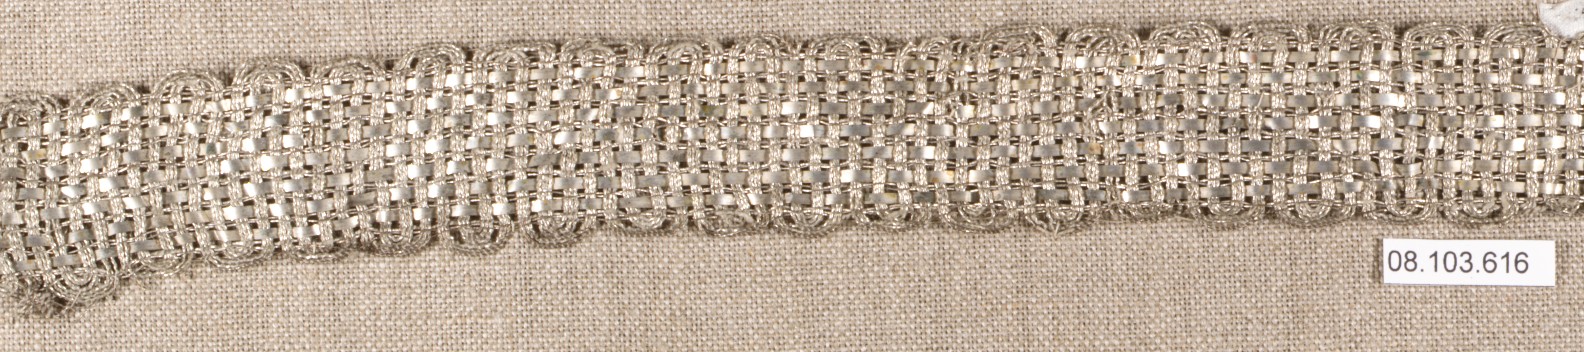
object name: galloon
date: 1701-1800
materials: metal thread